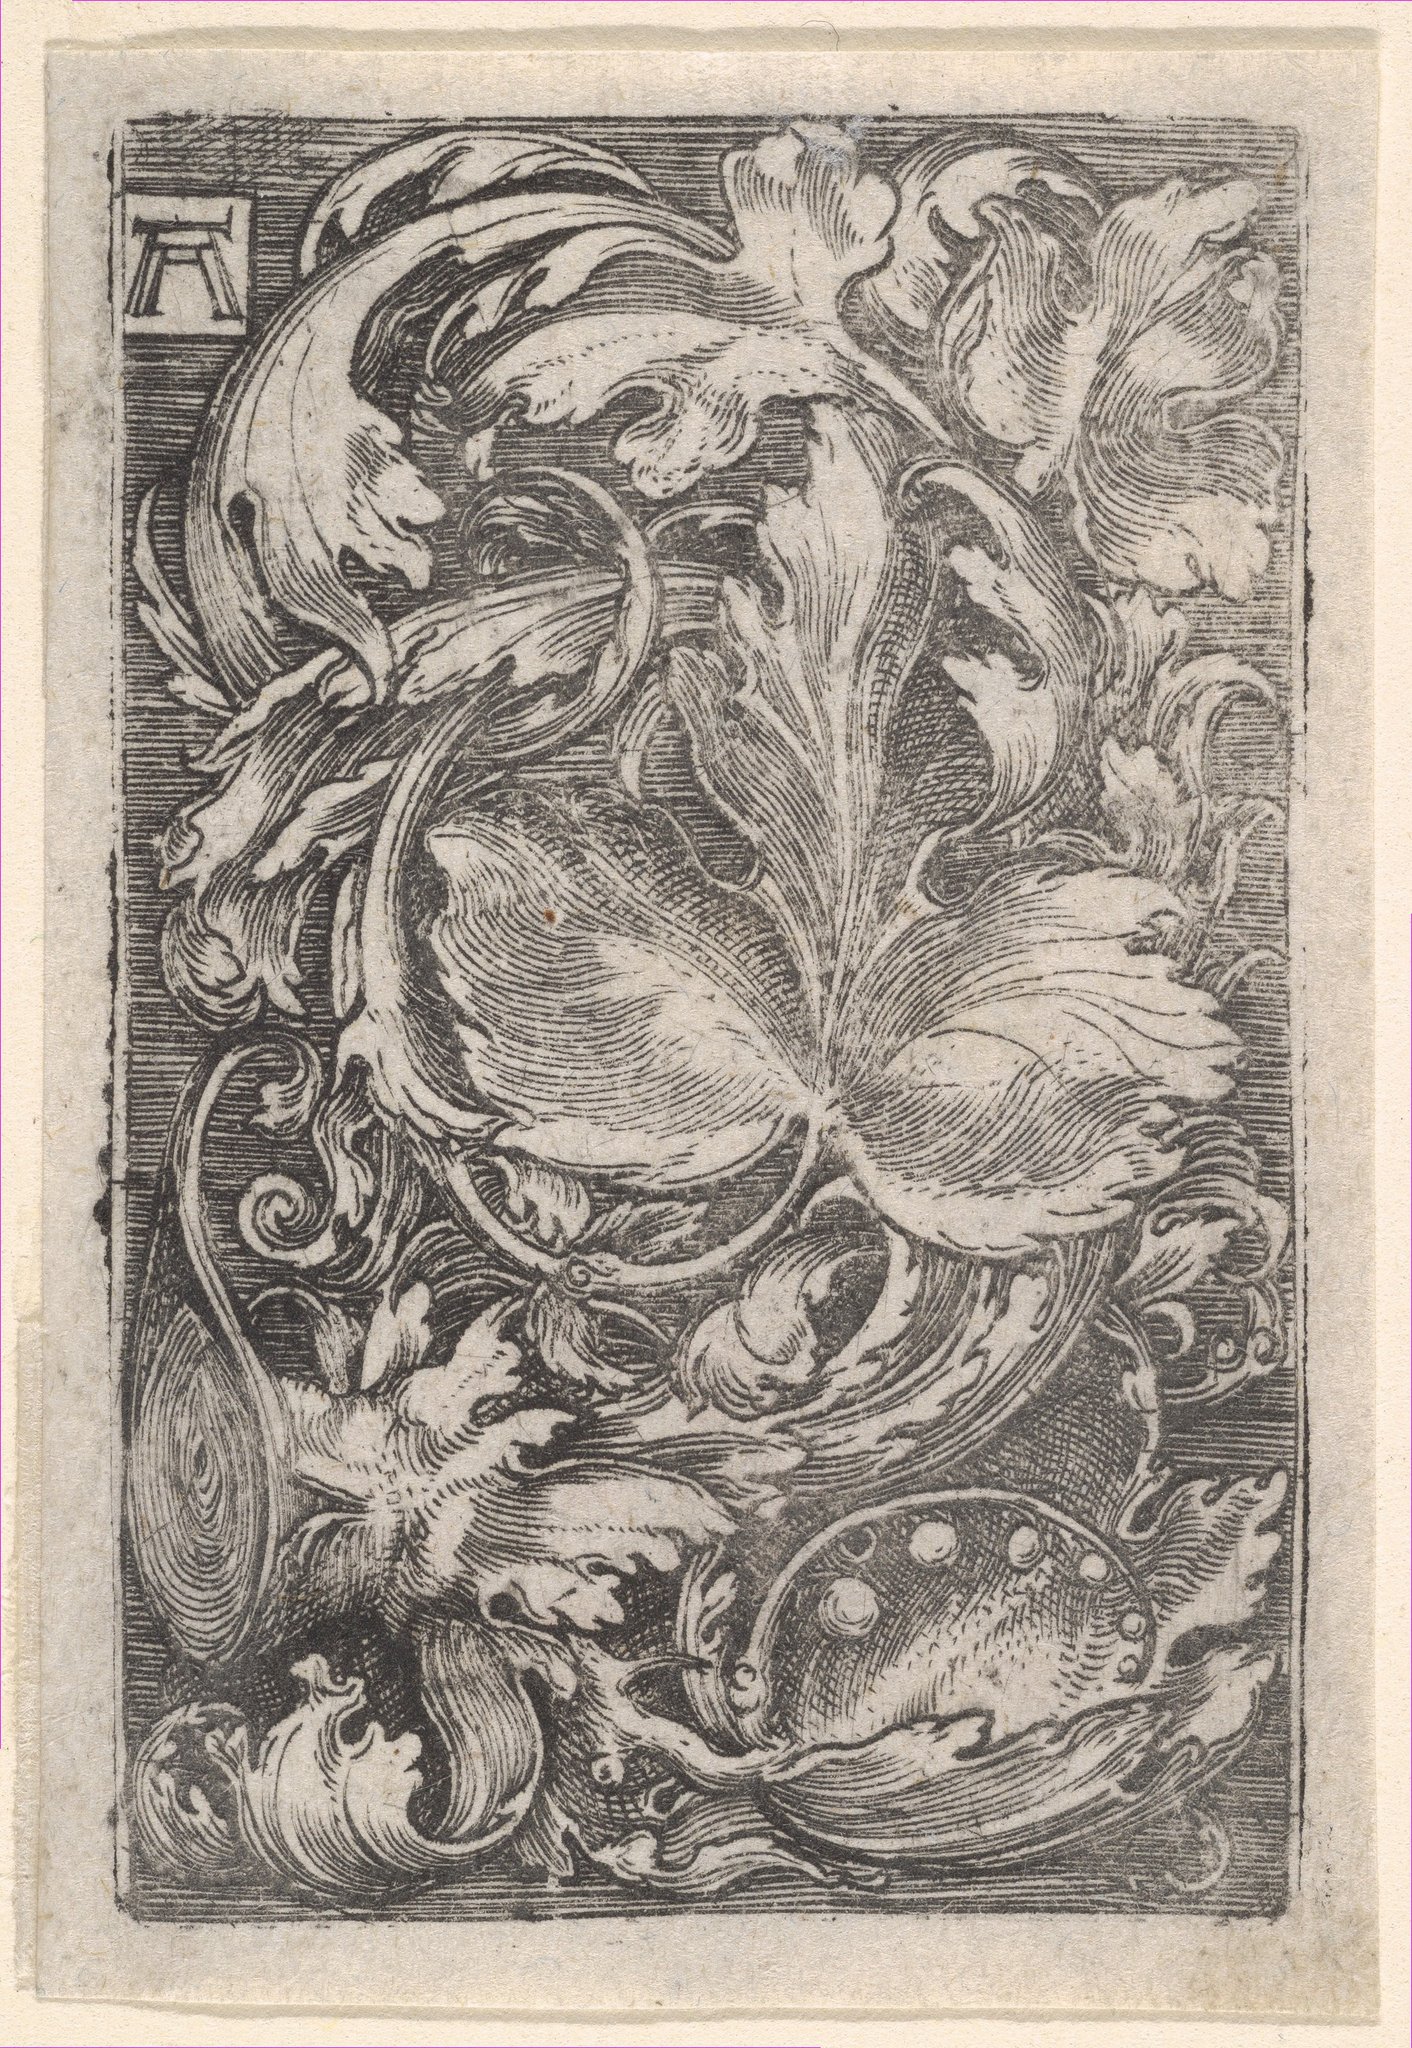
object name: print ornament architecture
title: Leaf Ornament with Lilies of the Valley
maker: albrecht altdorfer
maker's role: artist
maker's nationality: german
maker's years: 1480-1538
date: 1500-1538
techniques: engraving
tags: lilies,leaves